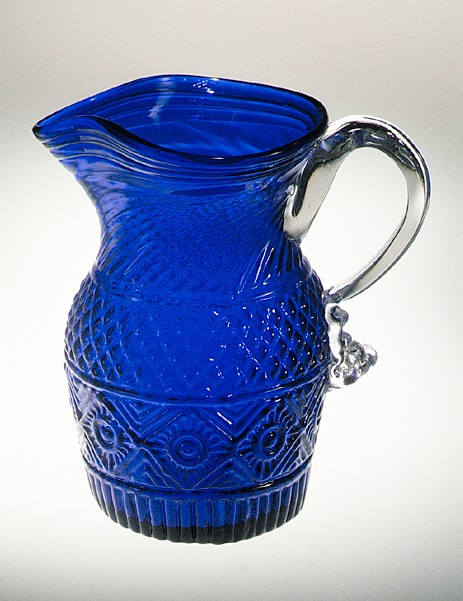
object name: cream jug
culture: american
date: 1820-1840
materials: glass, lead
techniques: glassblowing, molding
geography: united states